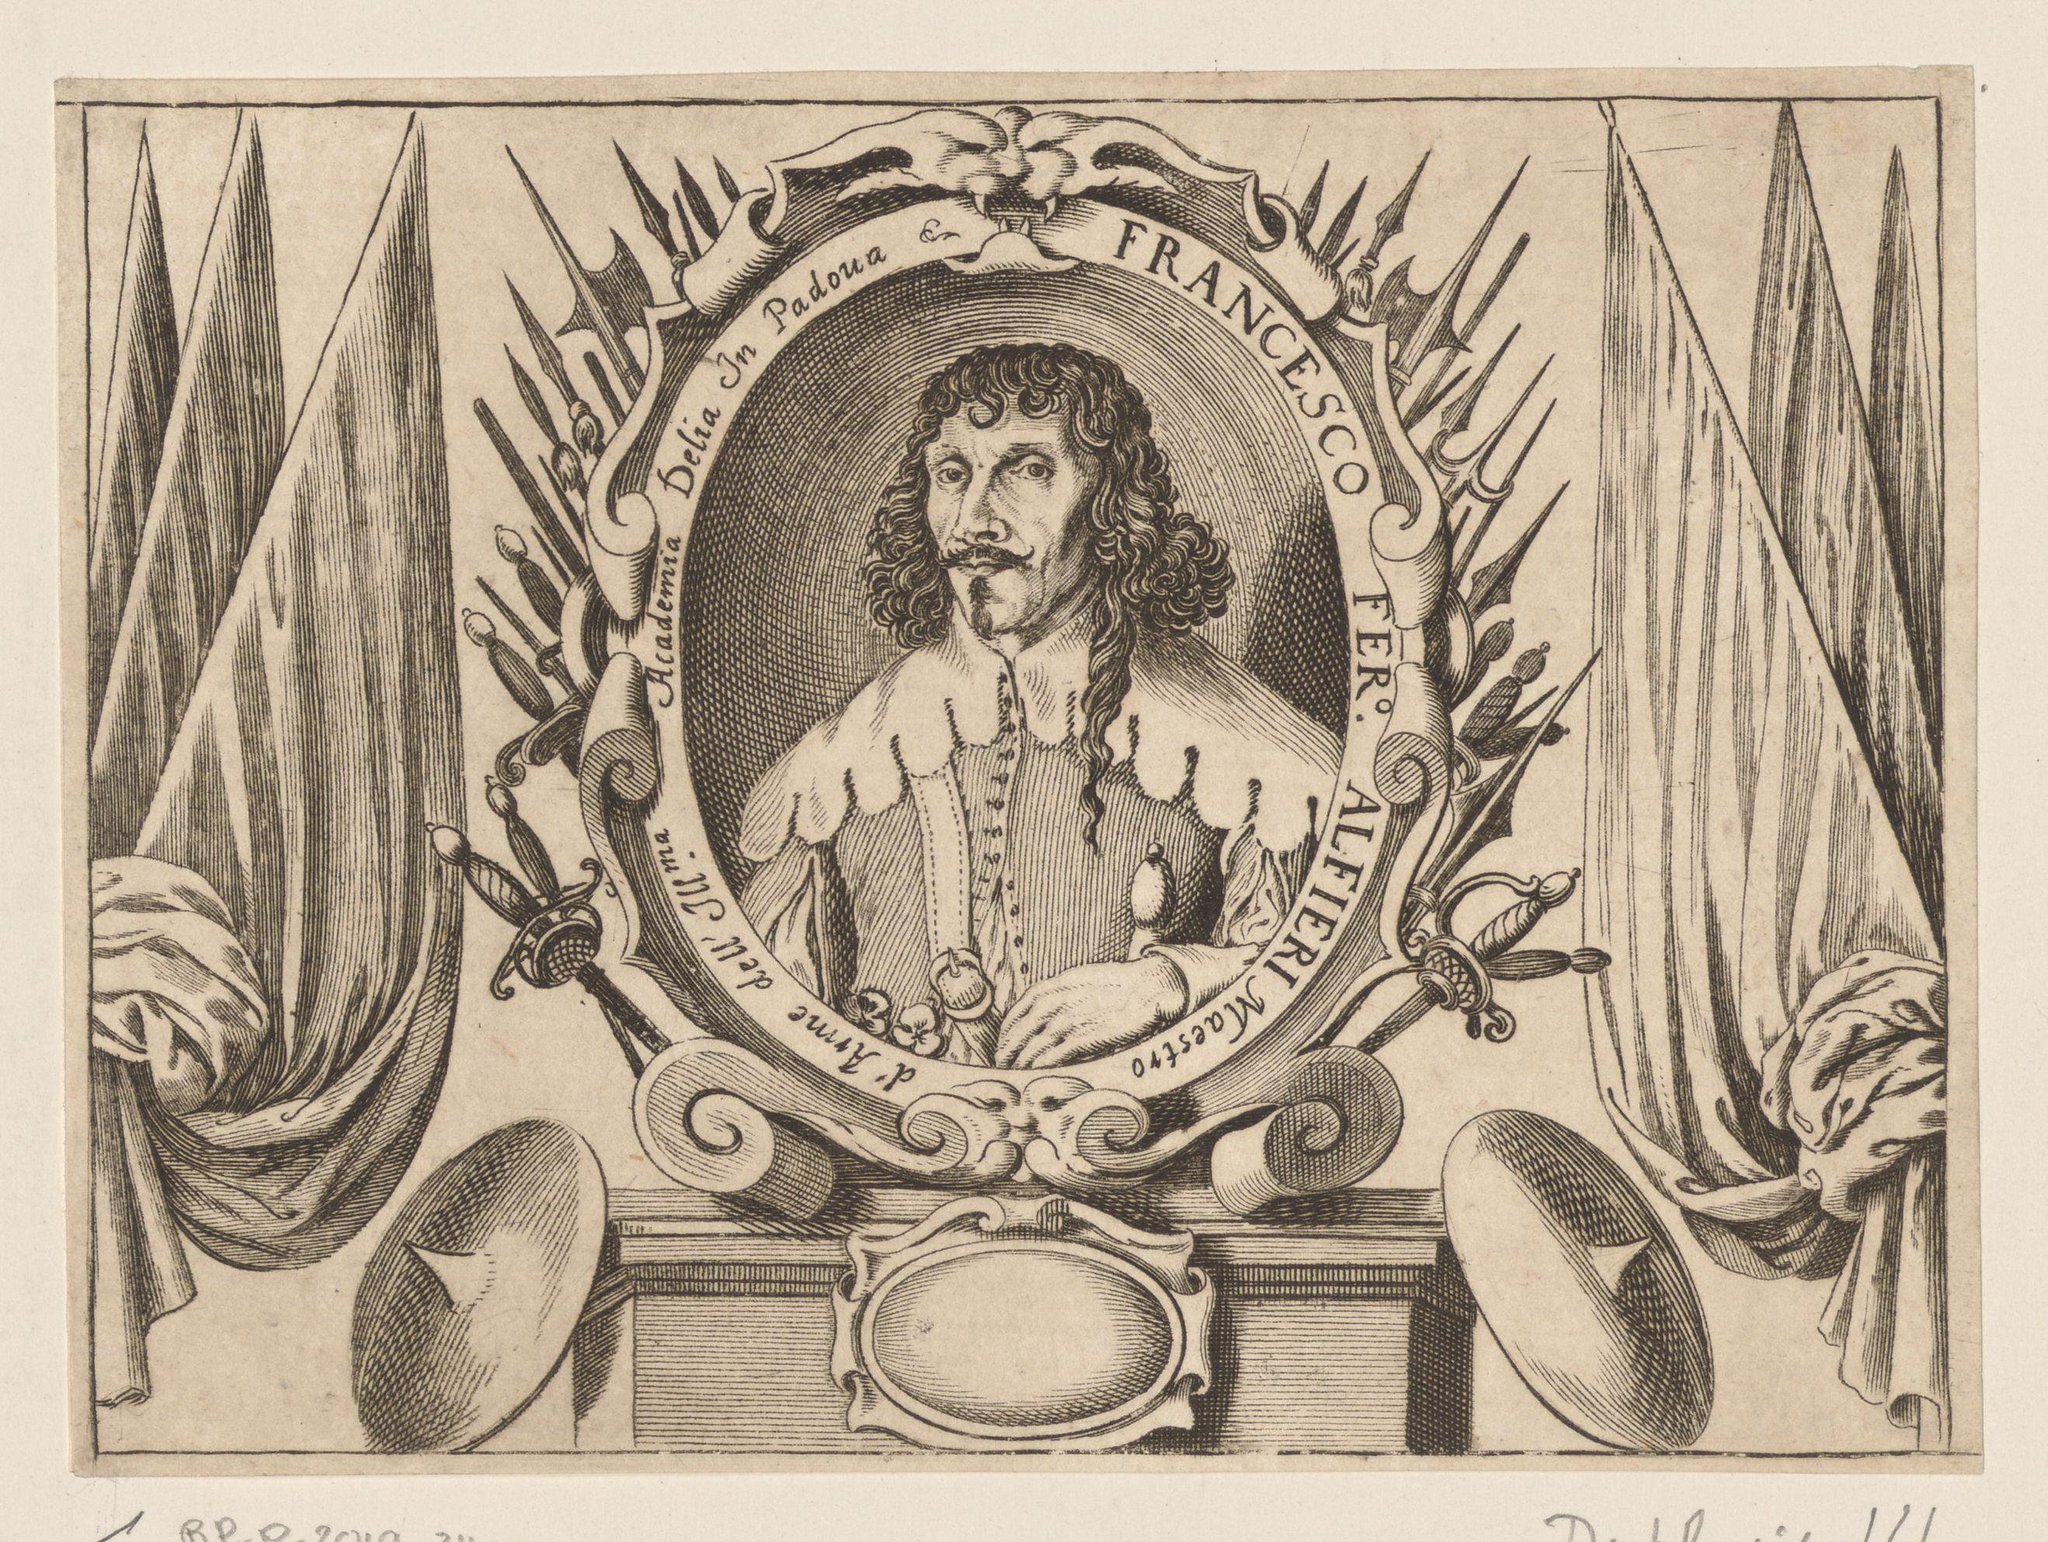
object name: print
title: Portret van Francesco Ferdinando Alfieri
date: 1640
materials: paper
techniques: engraving, etching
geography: padua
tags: historical persons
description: Prent uit: Alfieri, Francesco Ferdinando. La scherma. Padua: Sebastiono Sardi, 1640.